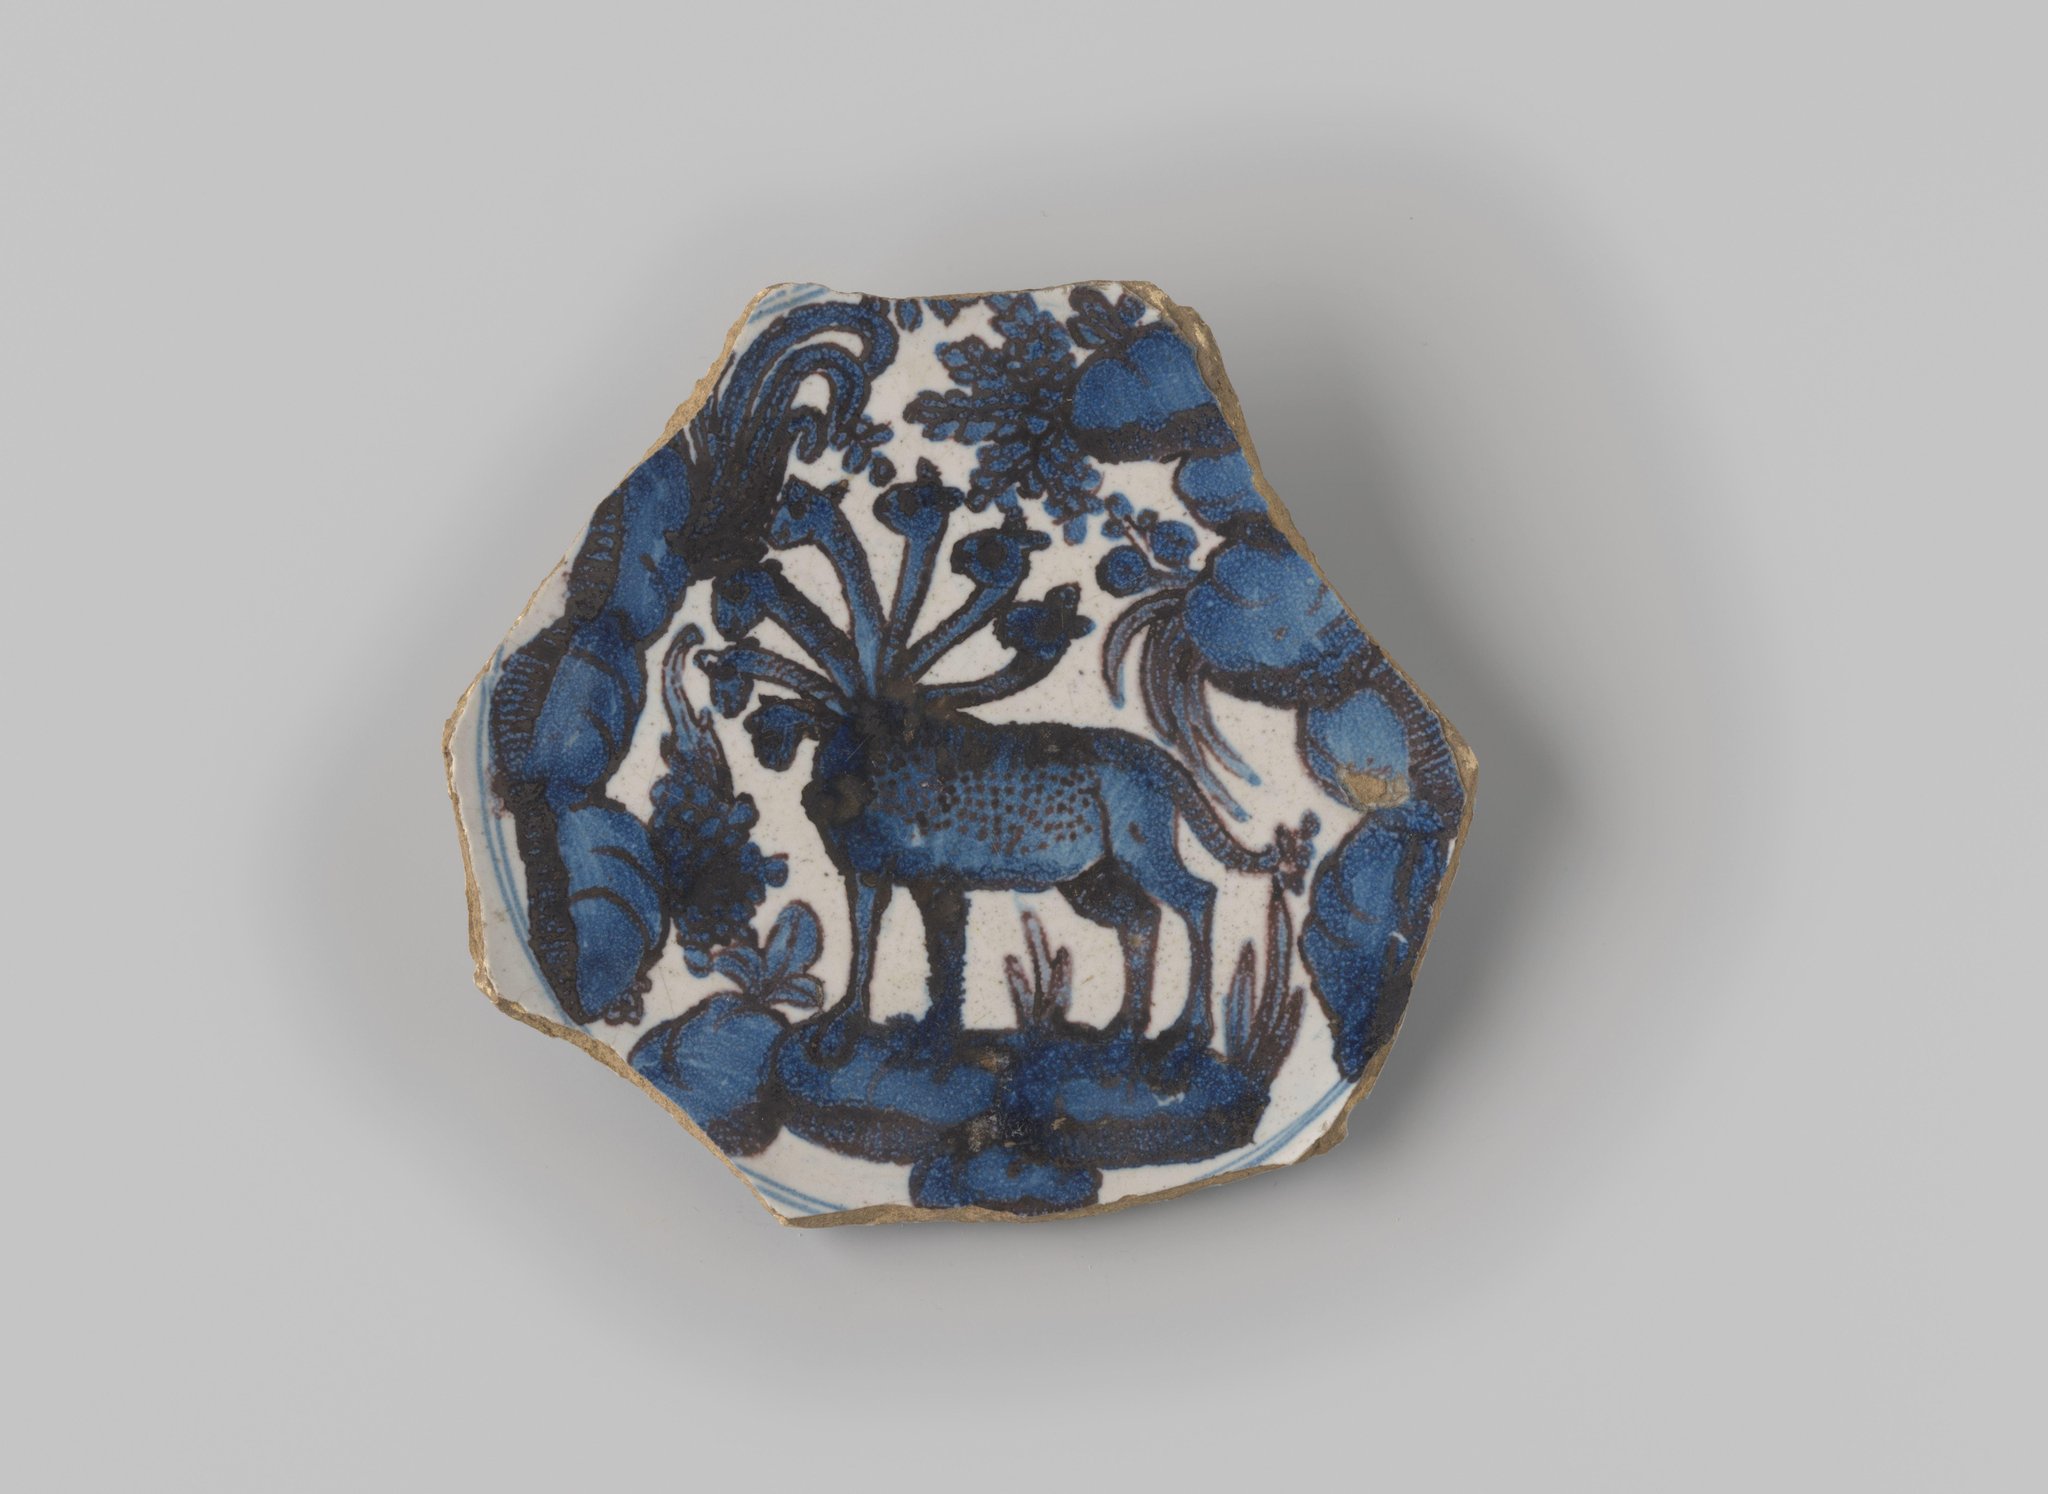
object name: fragment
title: Scherf van witbakkend aardewerk, met standring, voorzien van wit glazuur, net aan de achterzijde ringen en een vis in blauw, en aan de voorzijde een zevenkoppig dier in een landschap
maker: Anonymous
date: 1600-1650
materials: earthenware, glaze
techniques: maiolica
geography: northern netherlands